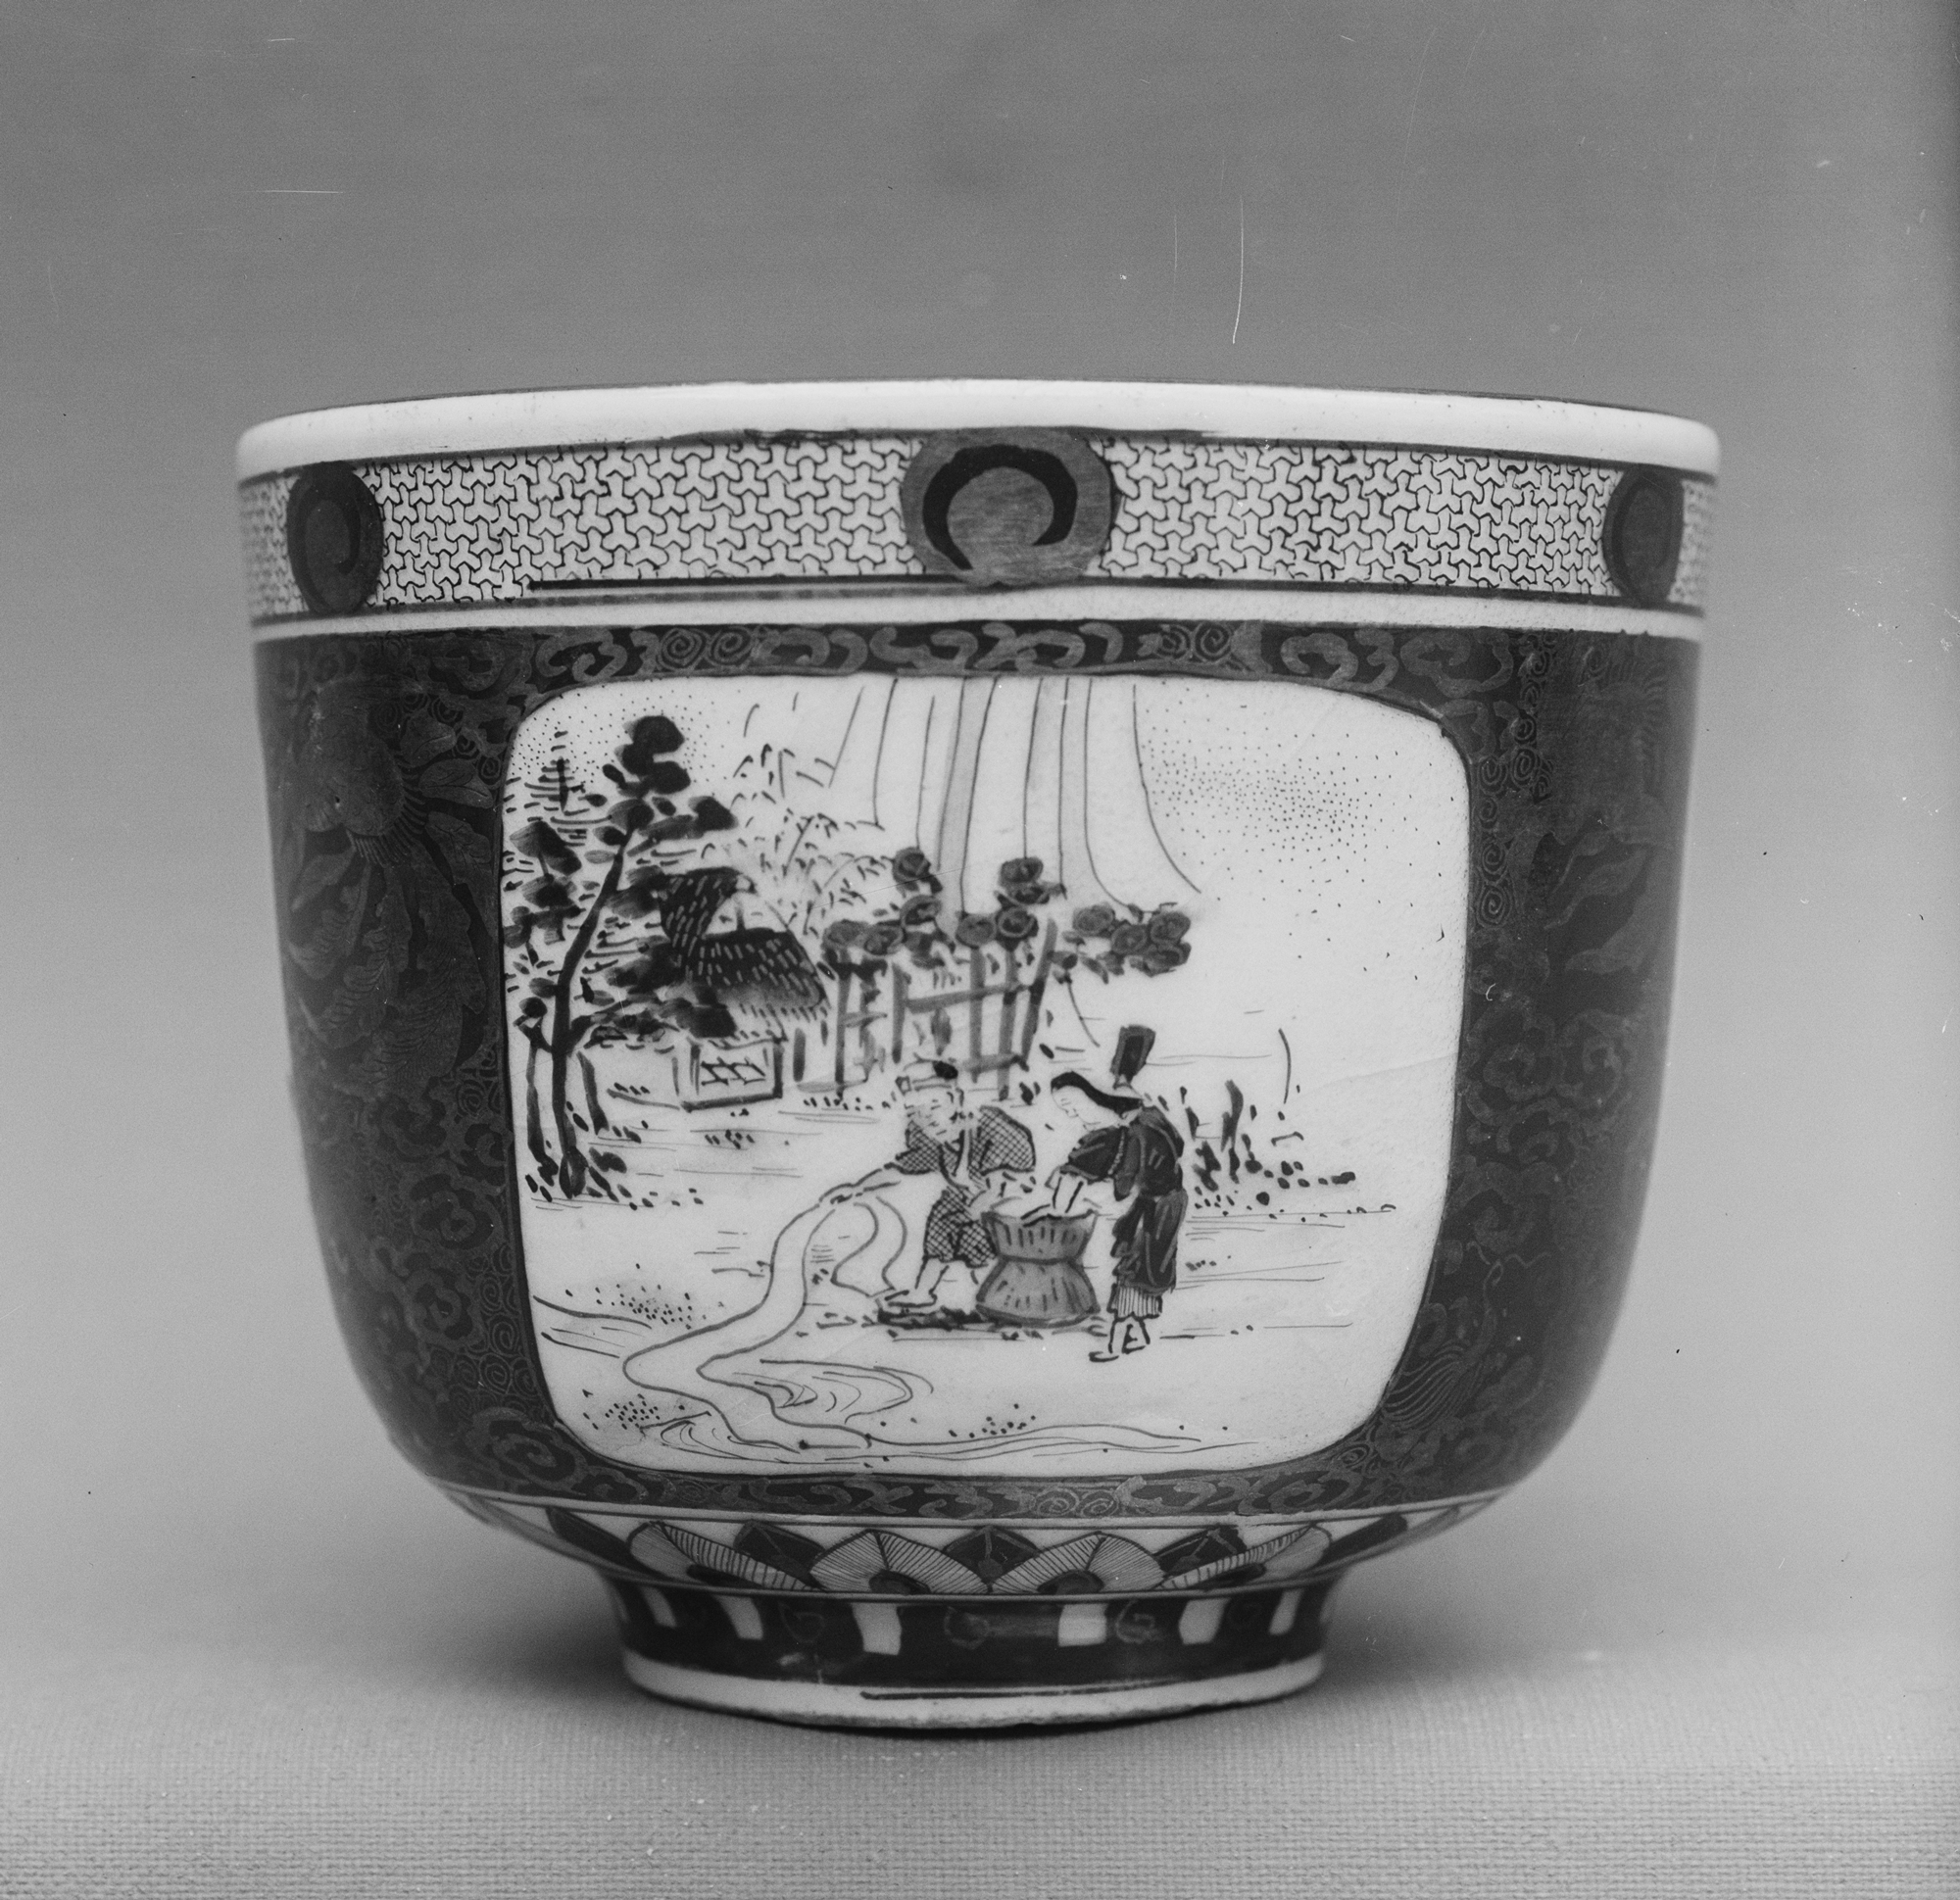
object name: cup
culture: japanese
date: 1801-1900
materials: gold, iron, porcelain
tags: human figures,trees